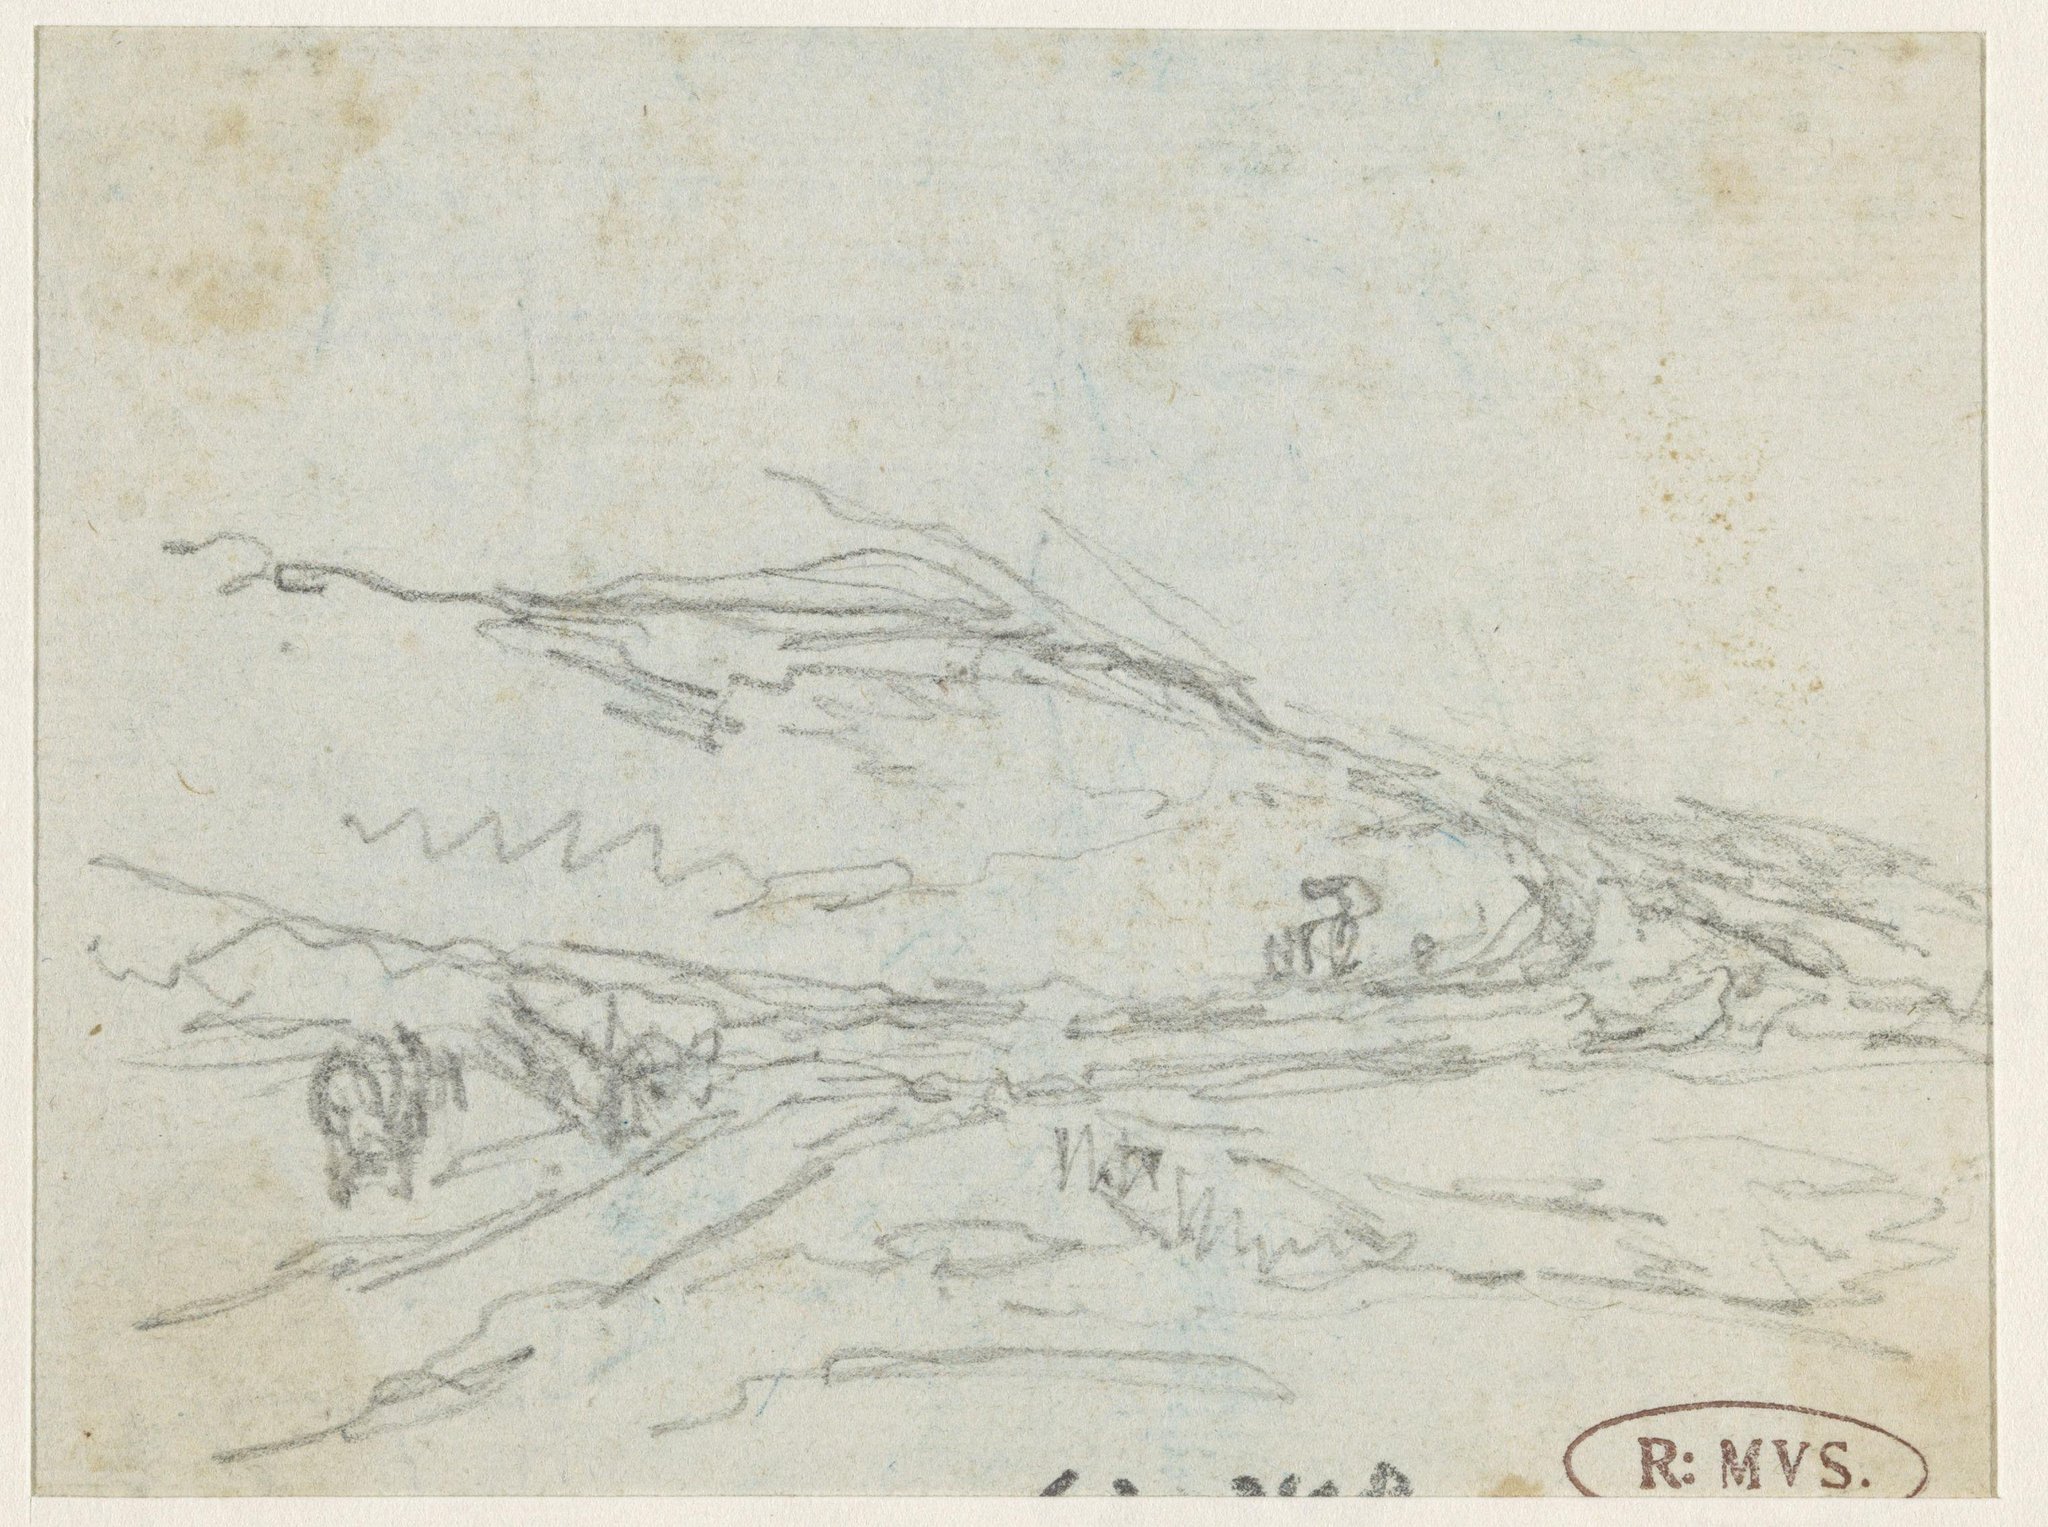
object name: drawing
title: Schets van heuvellandschap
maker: georges michel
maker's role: draughtsman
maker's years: 1763-1843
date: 1773-1843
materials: paper, pencil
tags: low hill country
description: Een van 120 tekeningen, afkomstig uit een 19e eeuws album met tekeningen van Georges Michel.